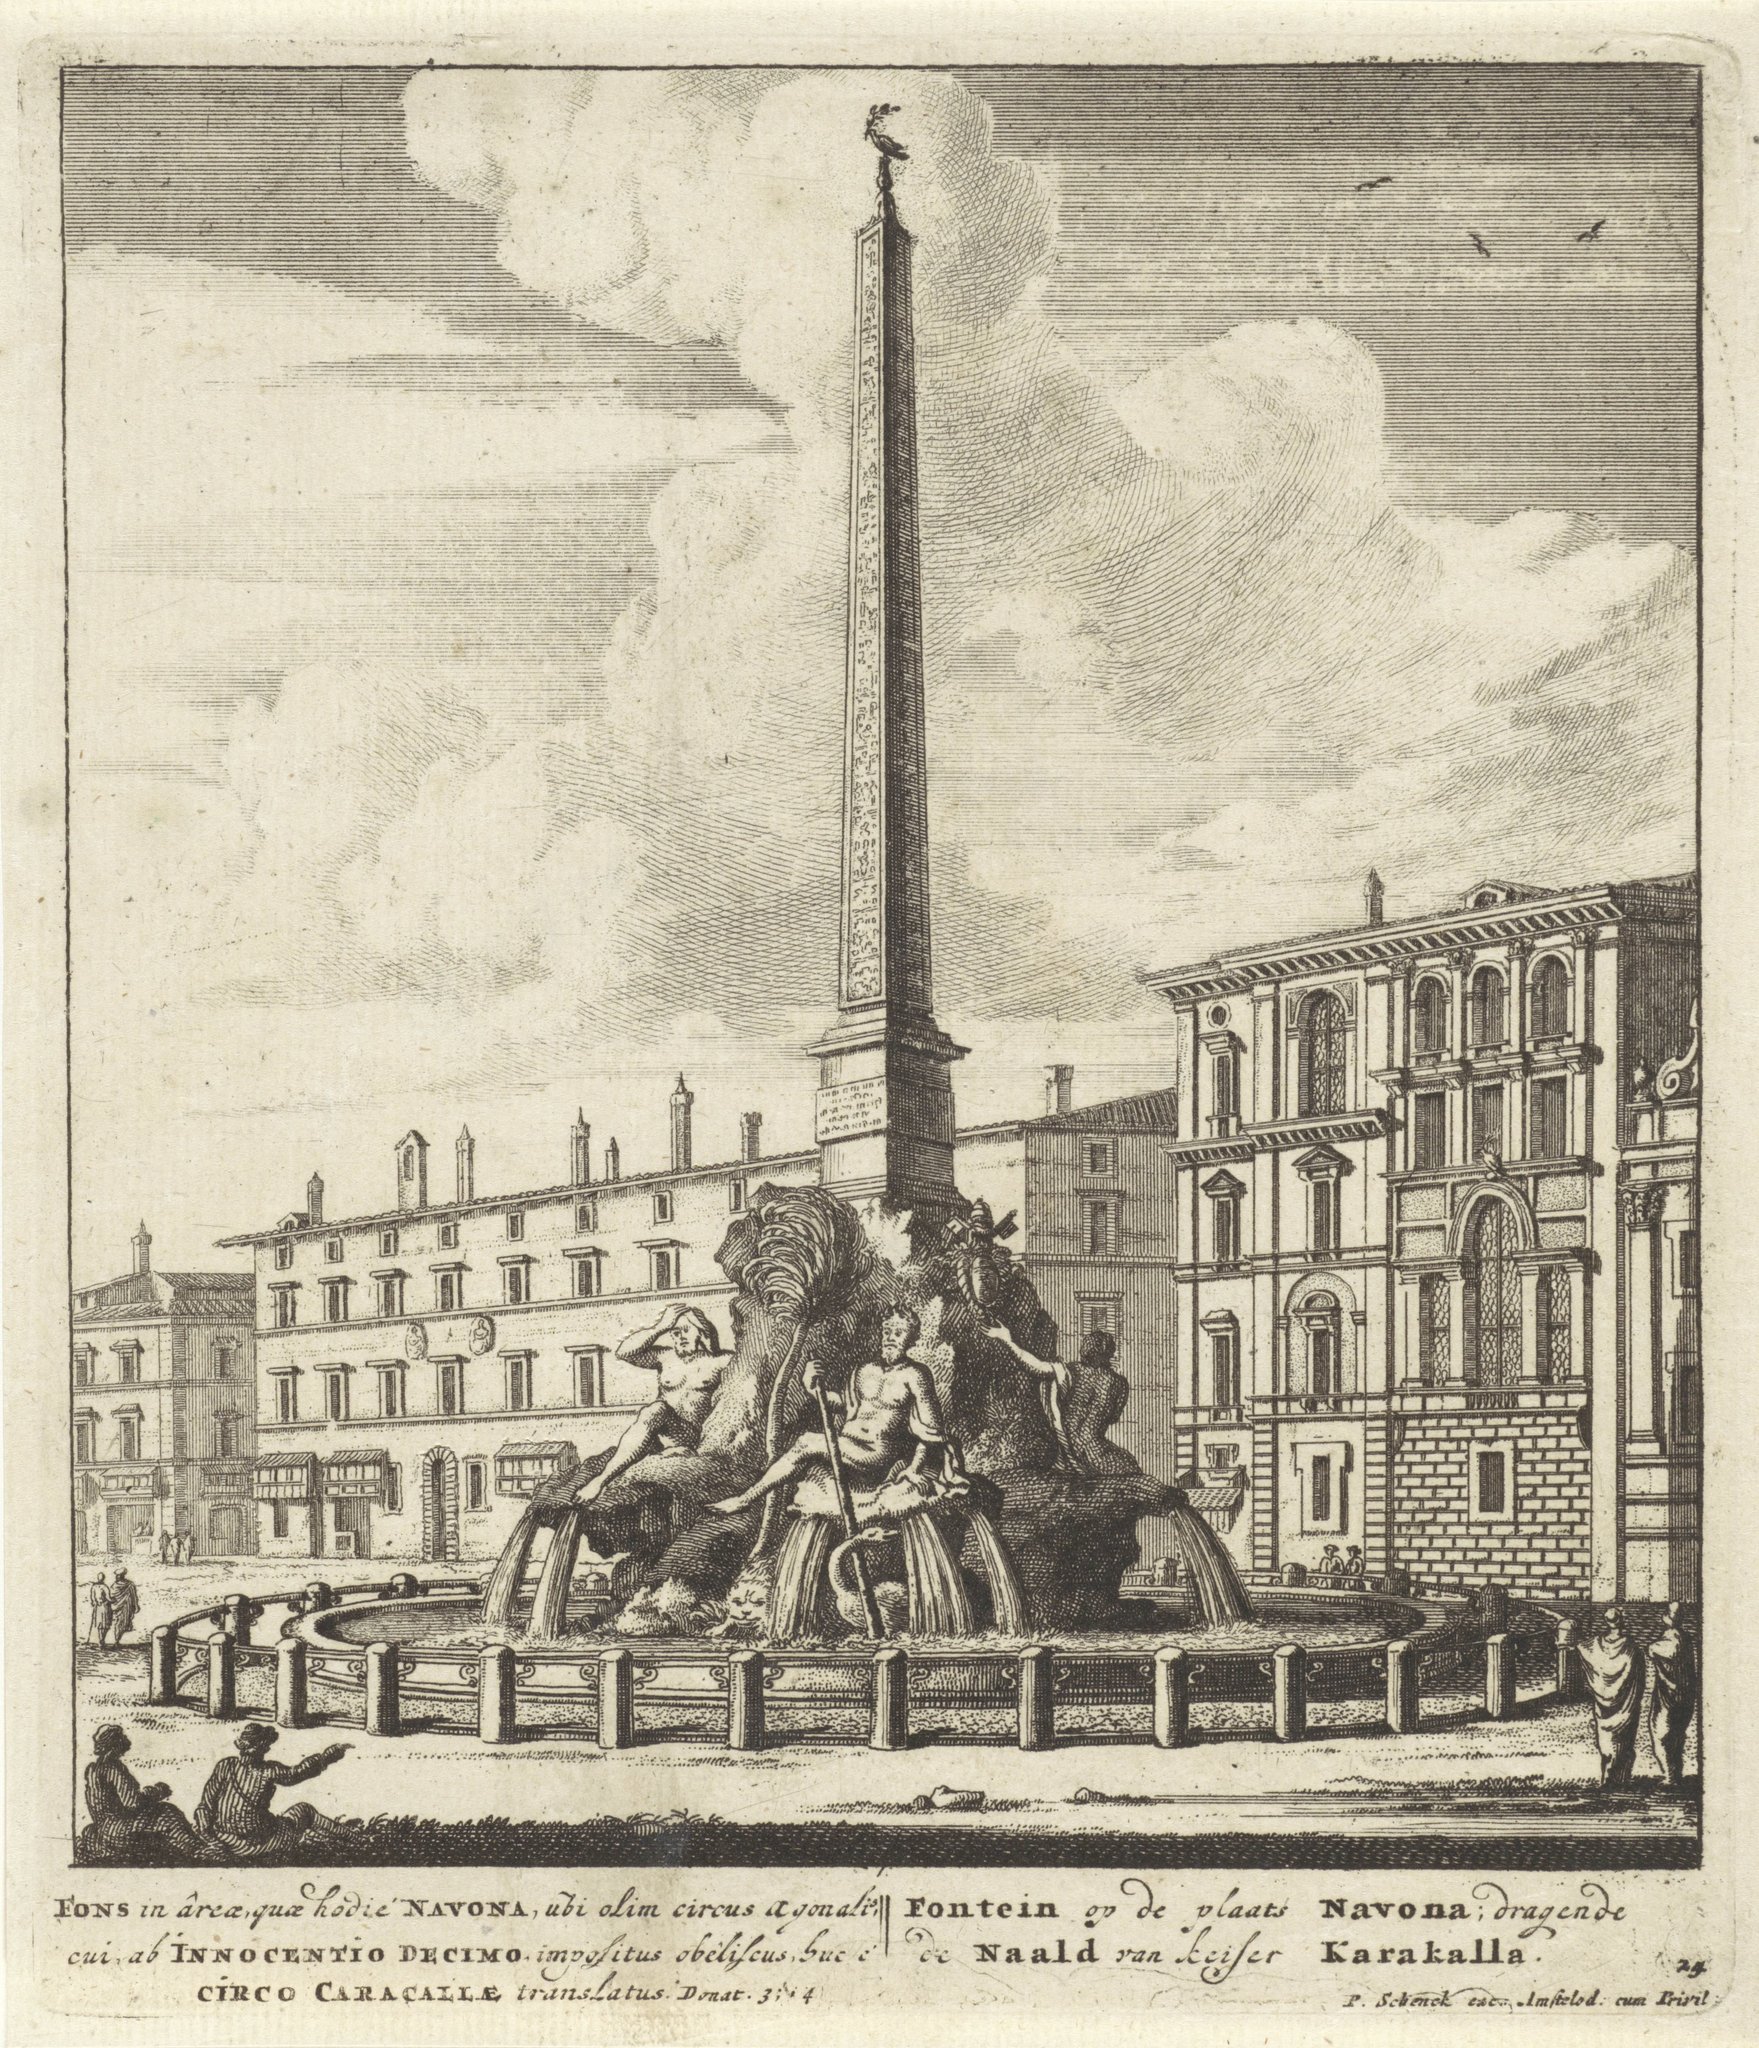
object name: print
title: Vierstromenfontein op het Piazza Navona te Rome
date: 1675-1711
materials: paper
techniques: etching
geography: amsterdam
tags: obelisk, needle, ornamental fountain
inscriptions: collector's mark: Lugt 2228